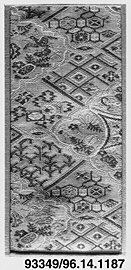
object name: piece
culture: japanese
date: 1701-1900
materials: silk